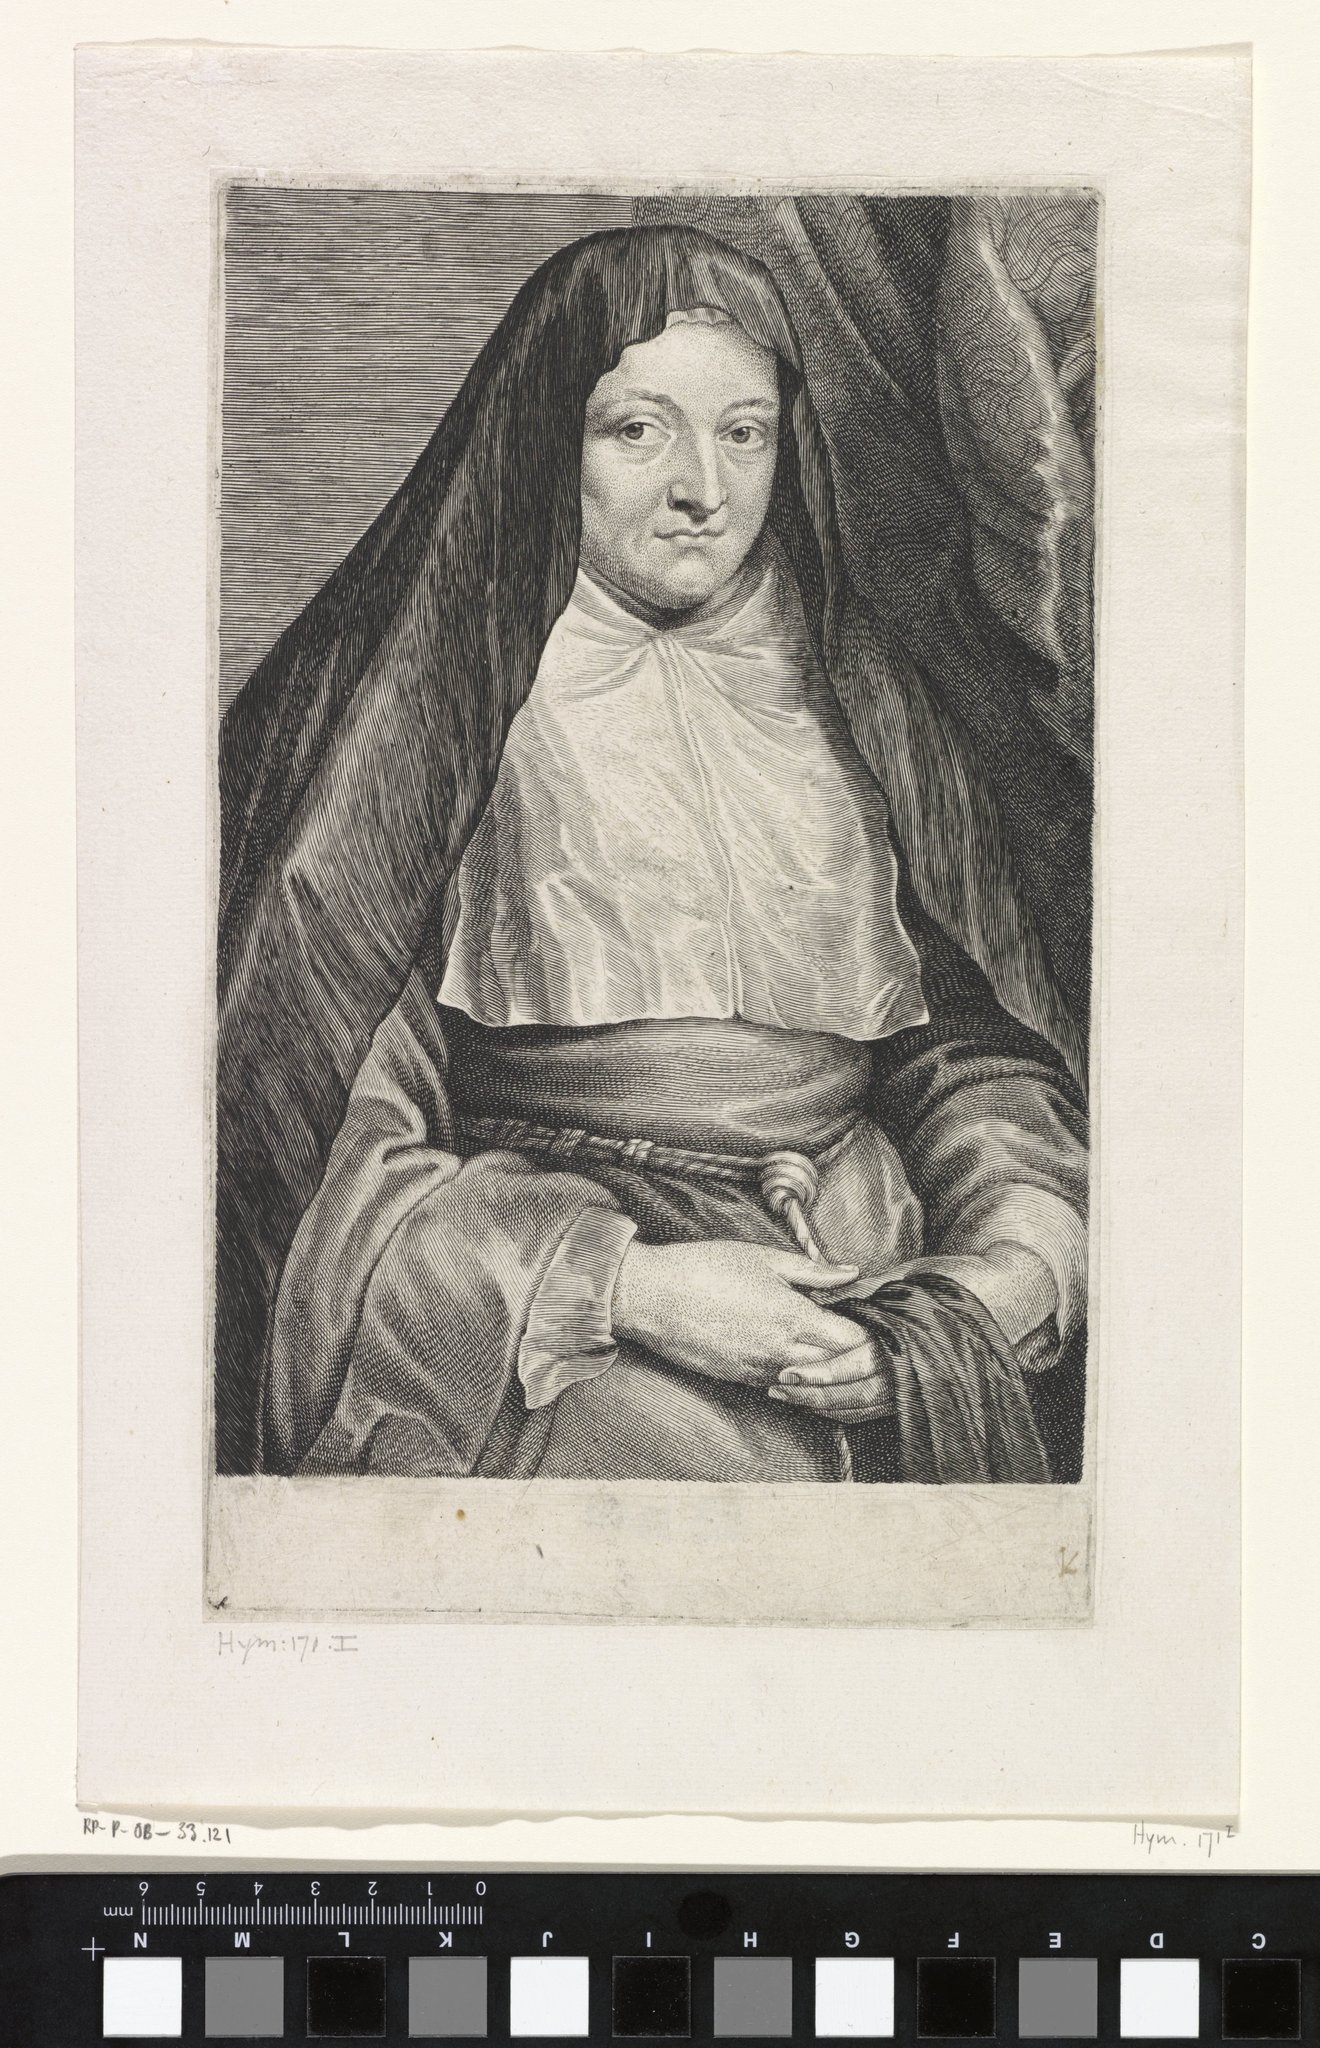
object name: print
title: Portret van Isabella Clara Eugenia, infante van Spanje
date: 1630-1646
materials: paper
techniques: engraving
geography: antwerp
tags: infante van spanje isabella clara eugenia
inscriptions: collector's mark: Lugt 240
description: Prent gebruikt voor: Icones principum, virorum doctorum, pictorum, chalcographorum, statuariorum nec non amatorum pictoriae artis numero centum ab Ant. van Dyck ad vivum expressae ejusque sumptibus aeri incisae. Antwerpen: Gillis Hendricx, [1645-1646].